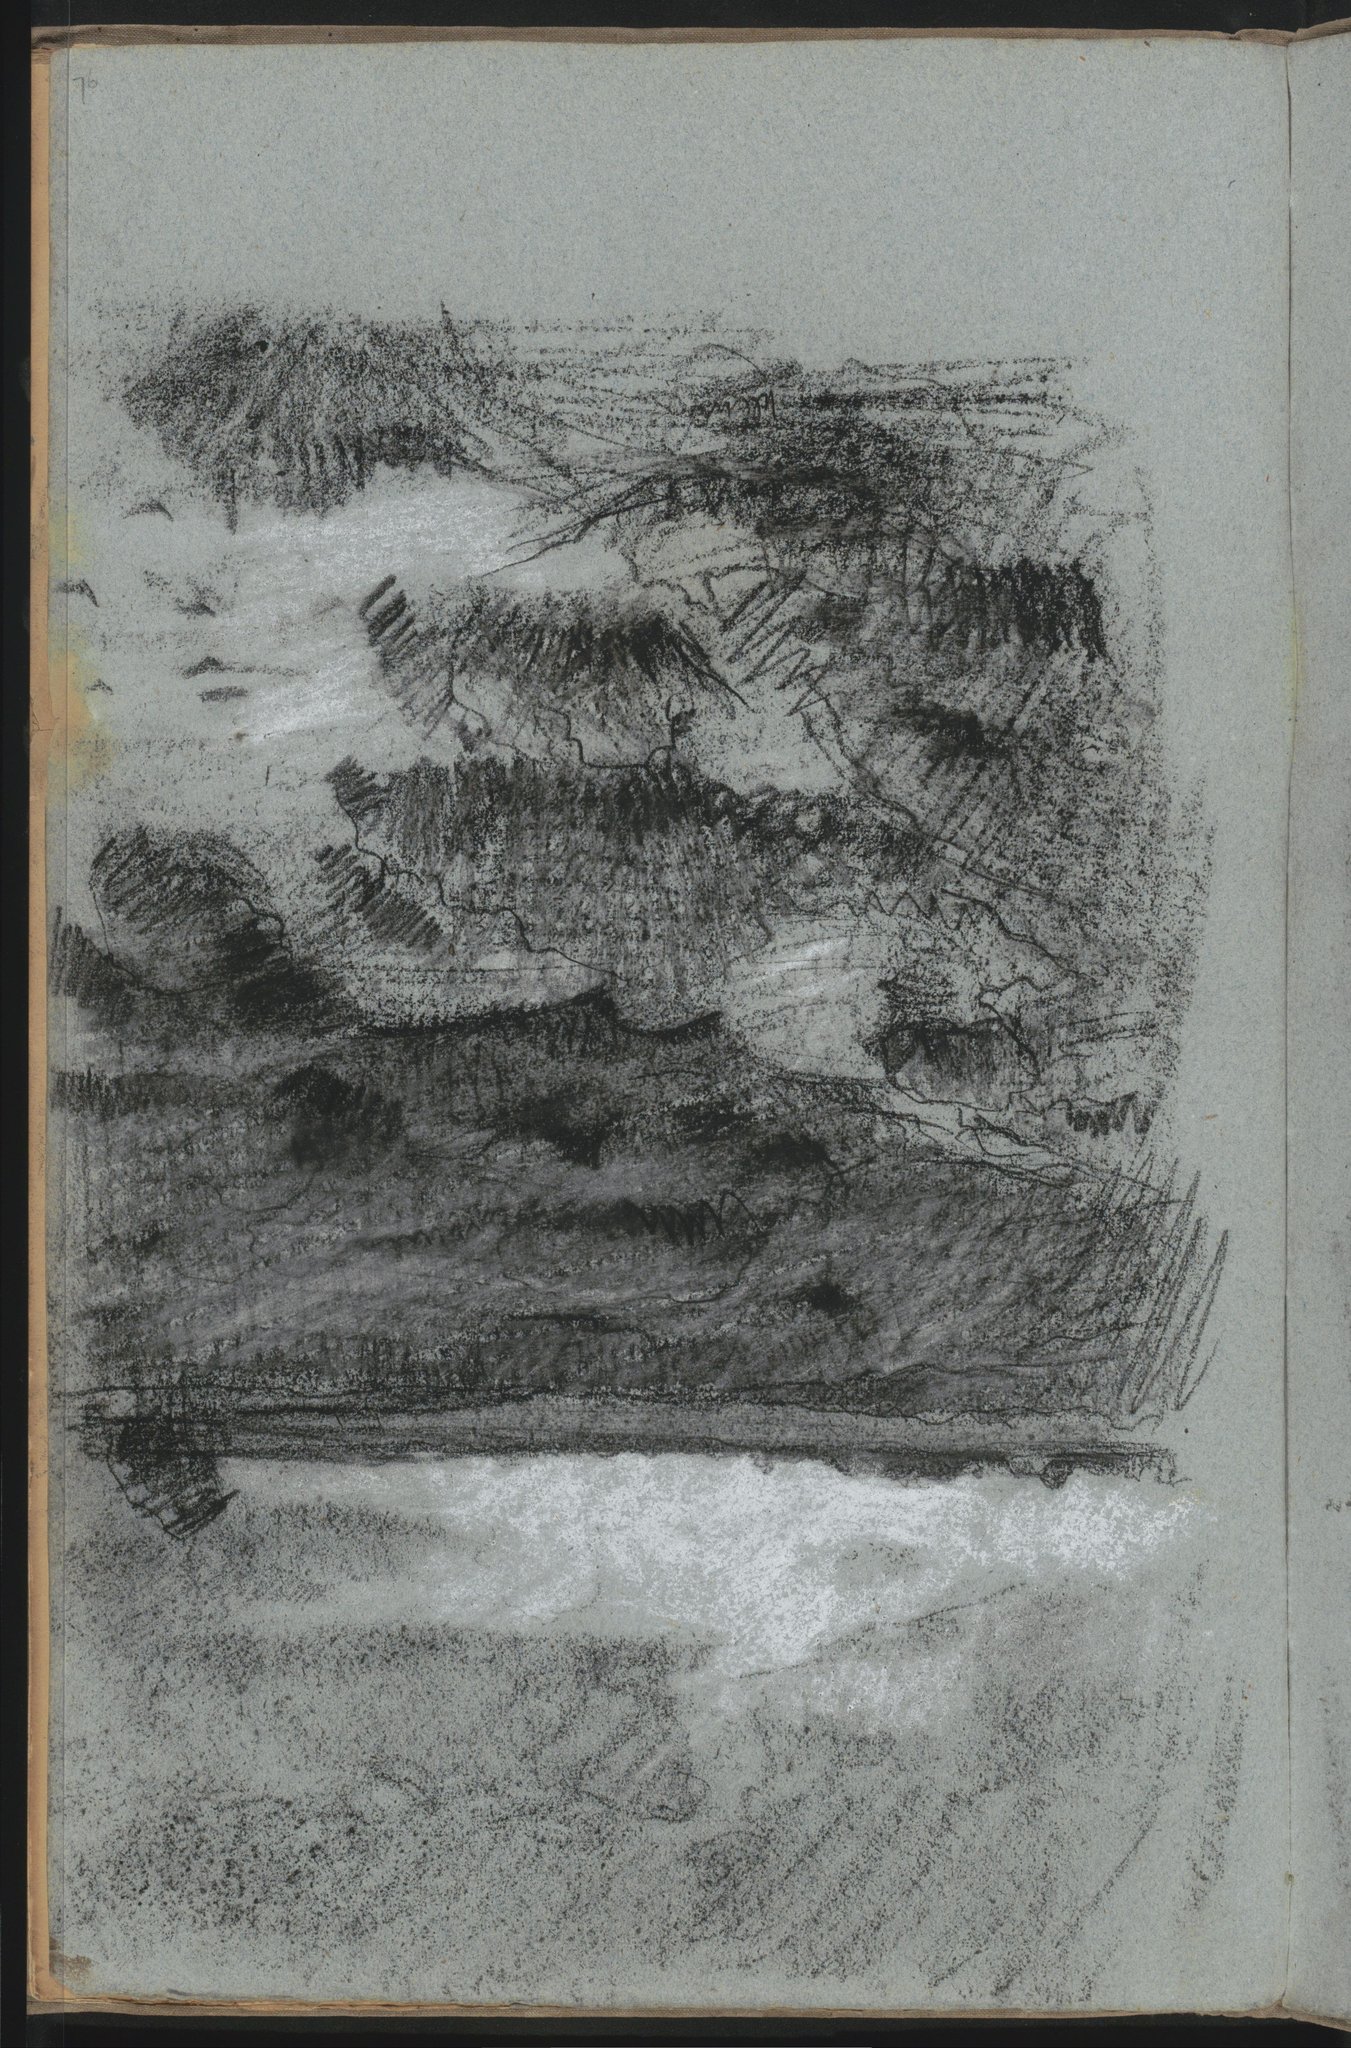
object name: sketchbook leaf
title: Landschap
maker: willem witsen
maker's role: draughtsman, painter, print maker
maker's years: 1860-1923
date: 1884-1887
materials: chalk, paper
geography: ewijkshoeve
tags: landscapes in the temperate zone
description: Pagina 76 uit een schetsboek met 42 bladen vervaardigd rond de Ewijkshoeve.